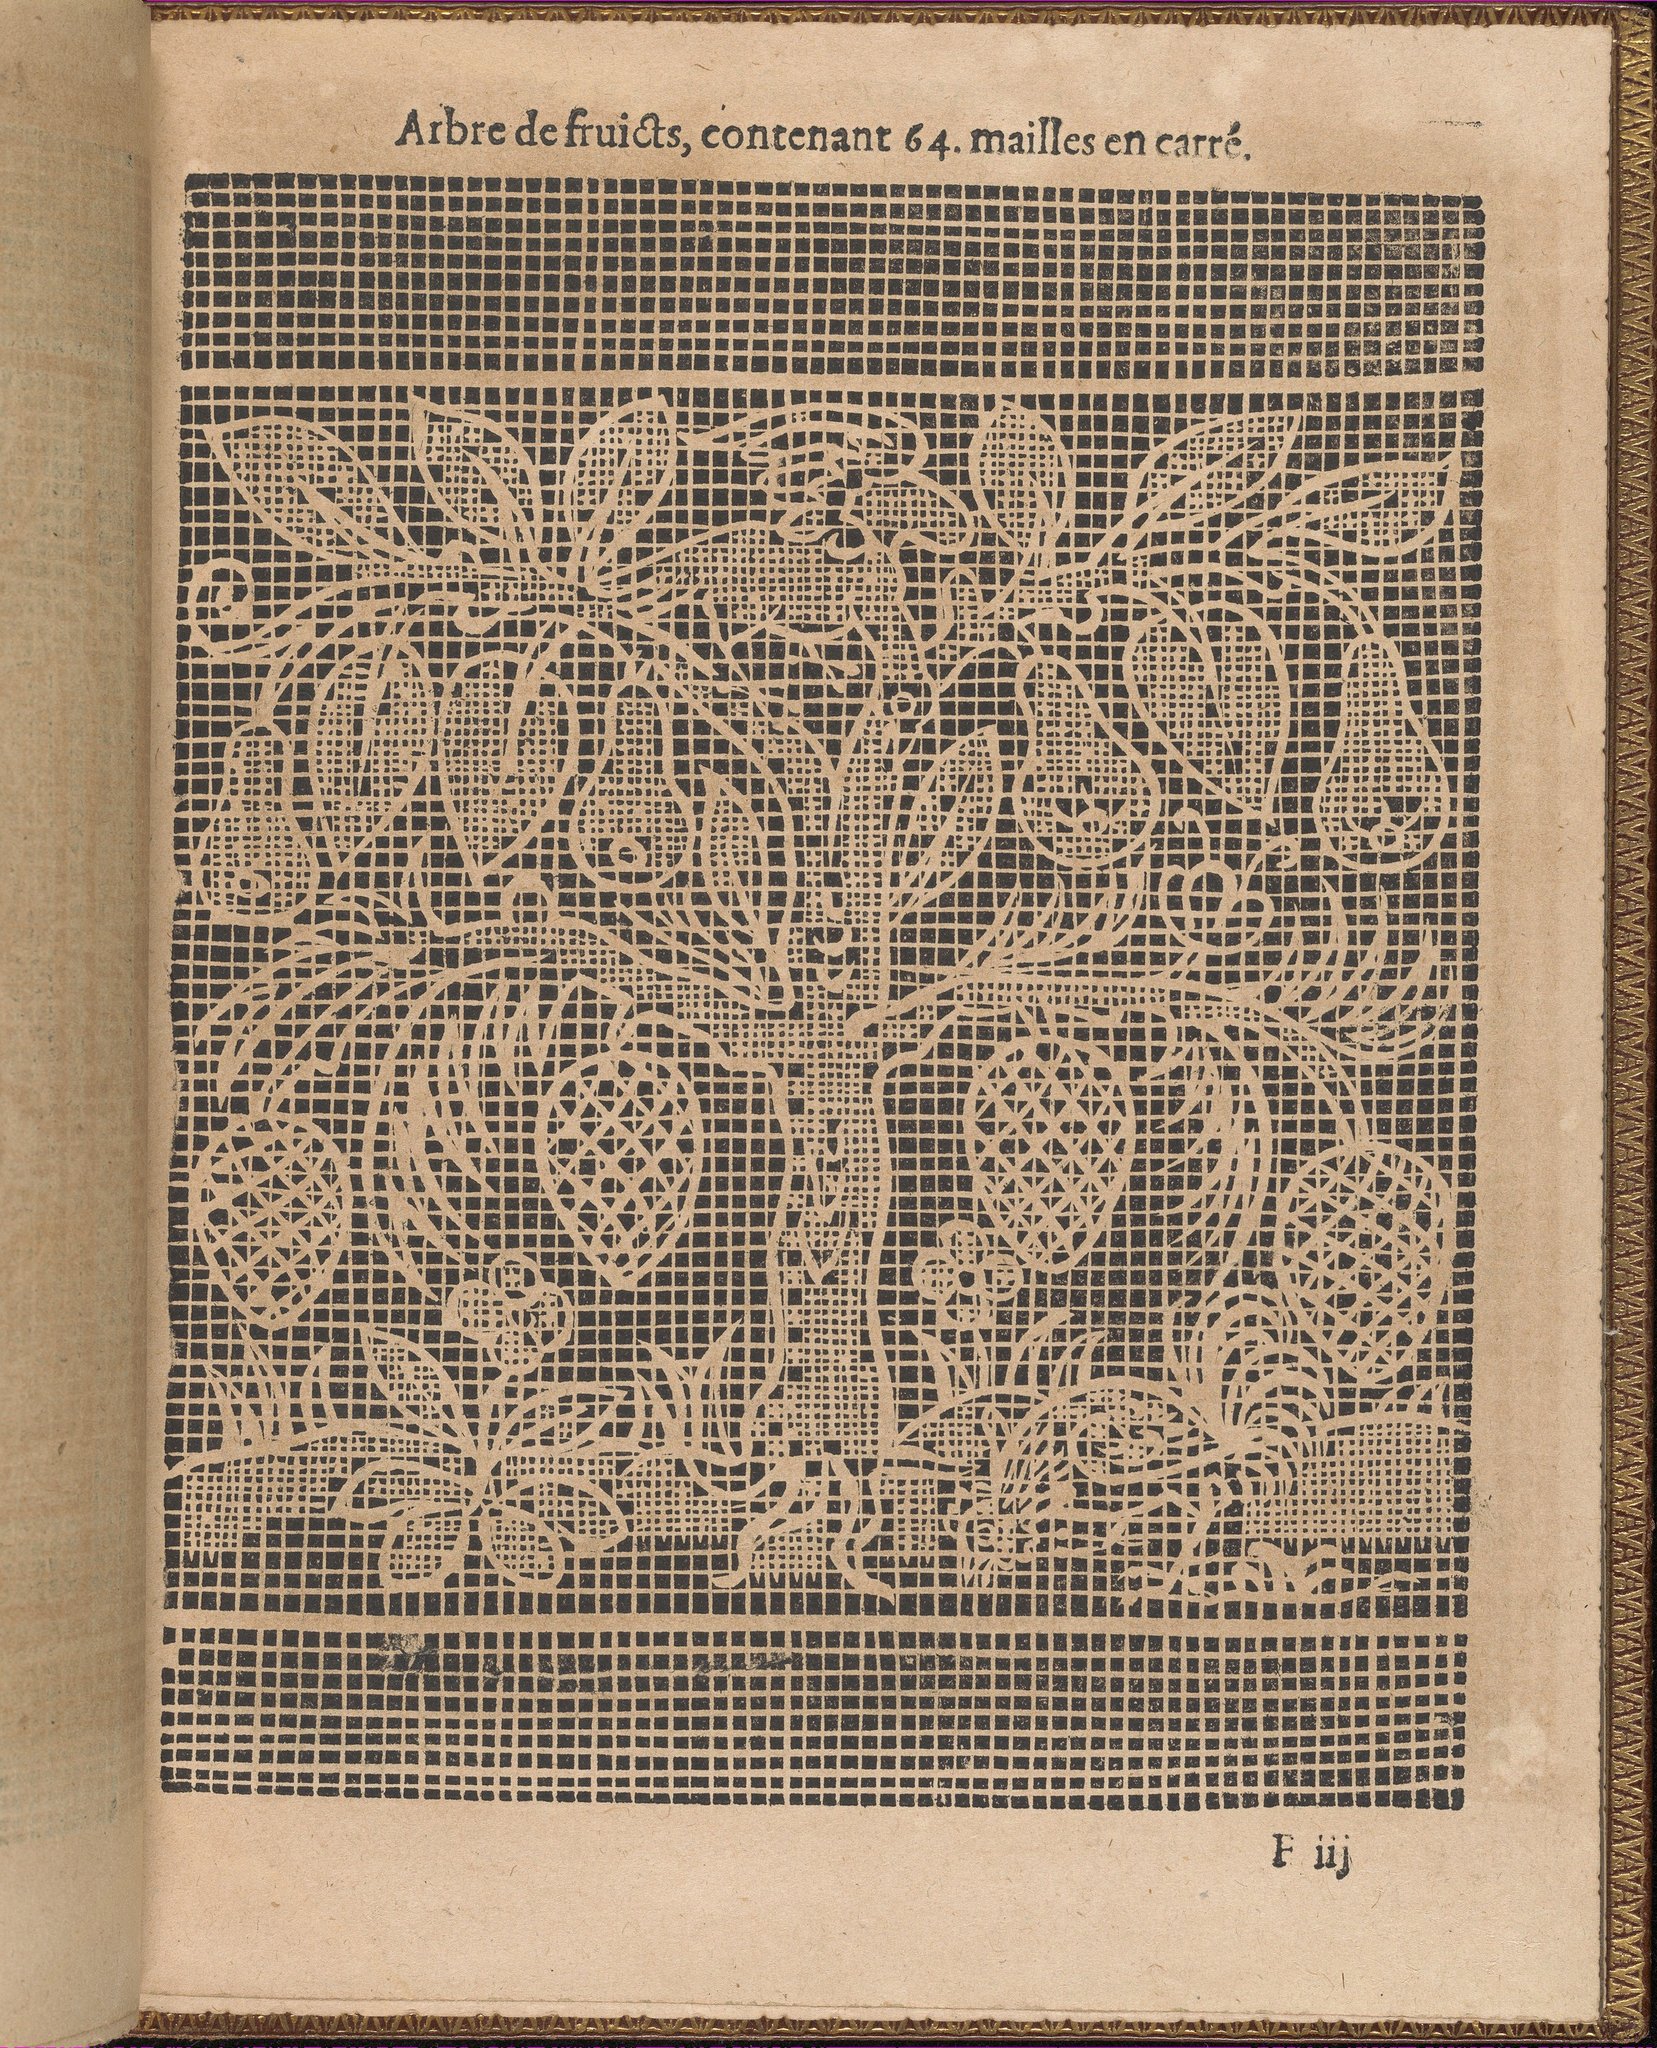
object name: book print ornament architecture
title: La Pratique de l'Aiguille, page 22 (recto)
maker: matthias mignerak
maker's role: author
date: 1605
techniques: woodcut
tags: fruit,roosters